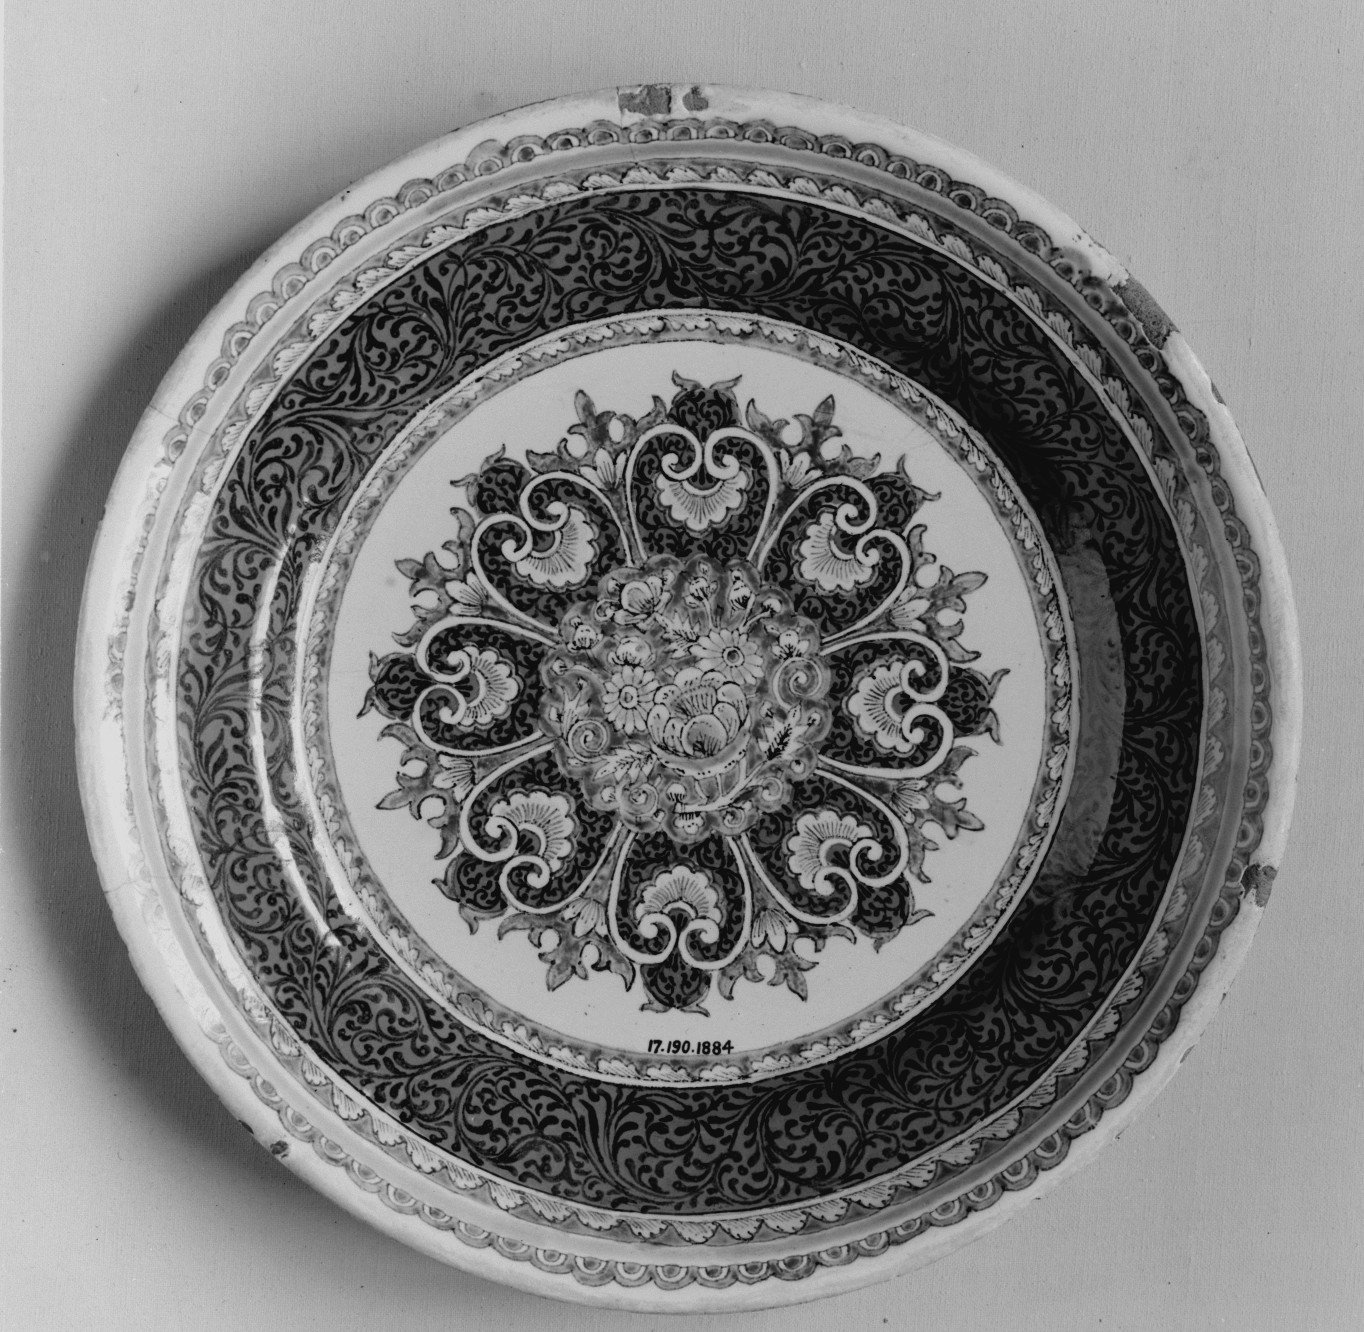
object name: plate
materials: faience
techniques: glazing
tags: flowers